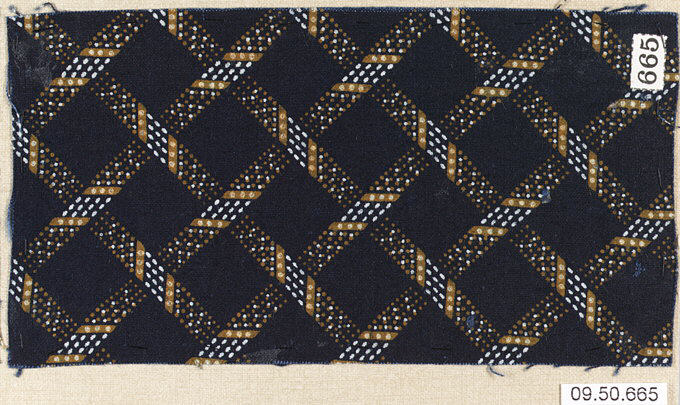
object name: piece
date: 1801-1900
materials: cotton